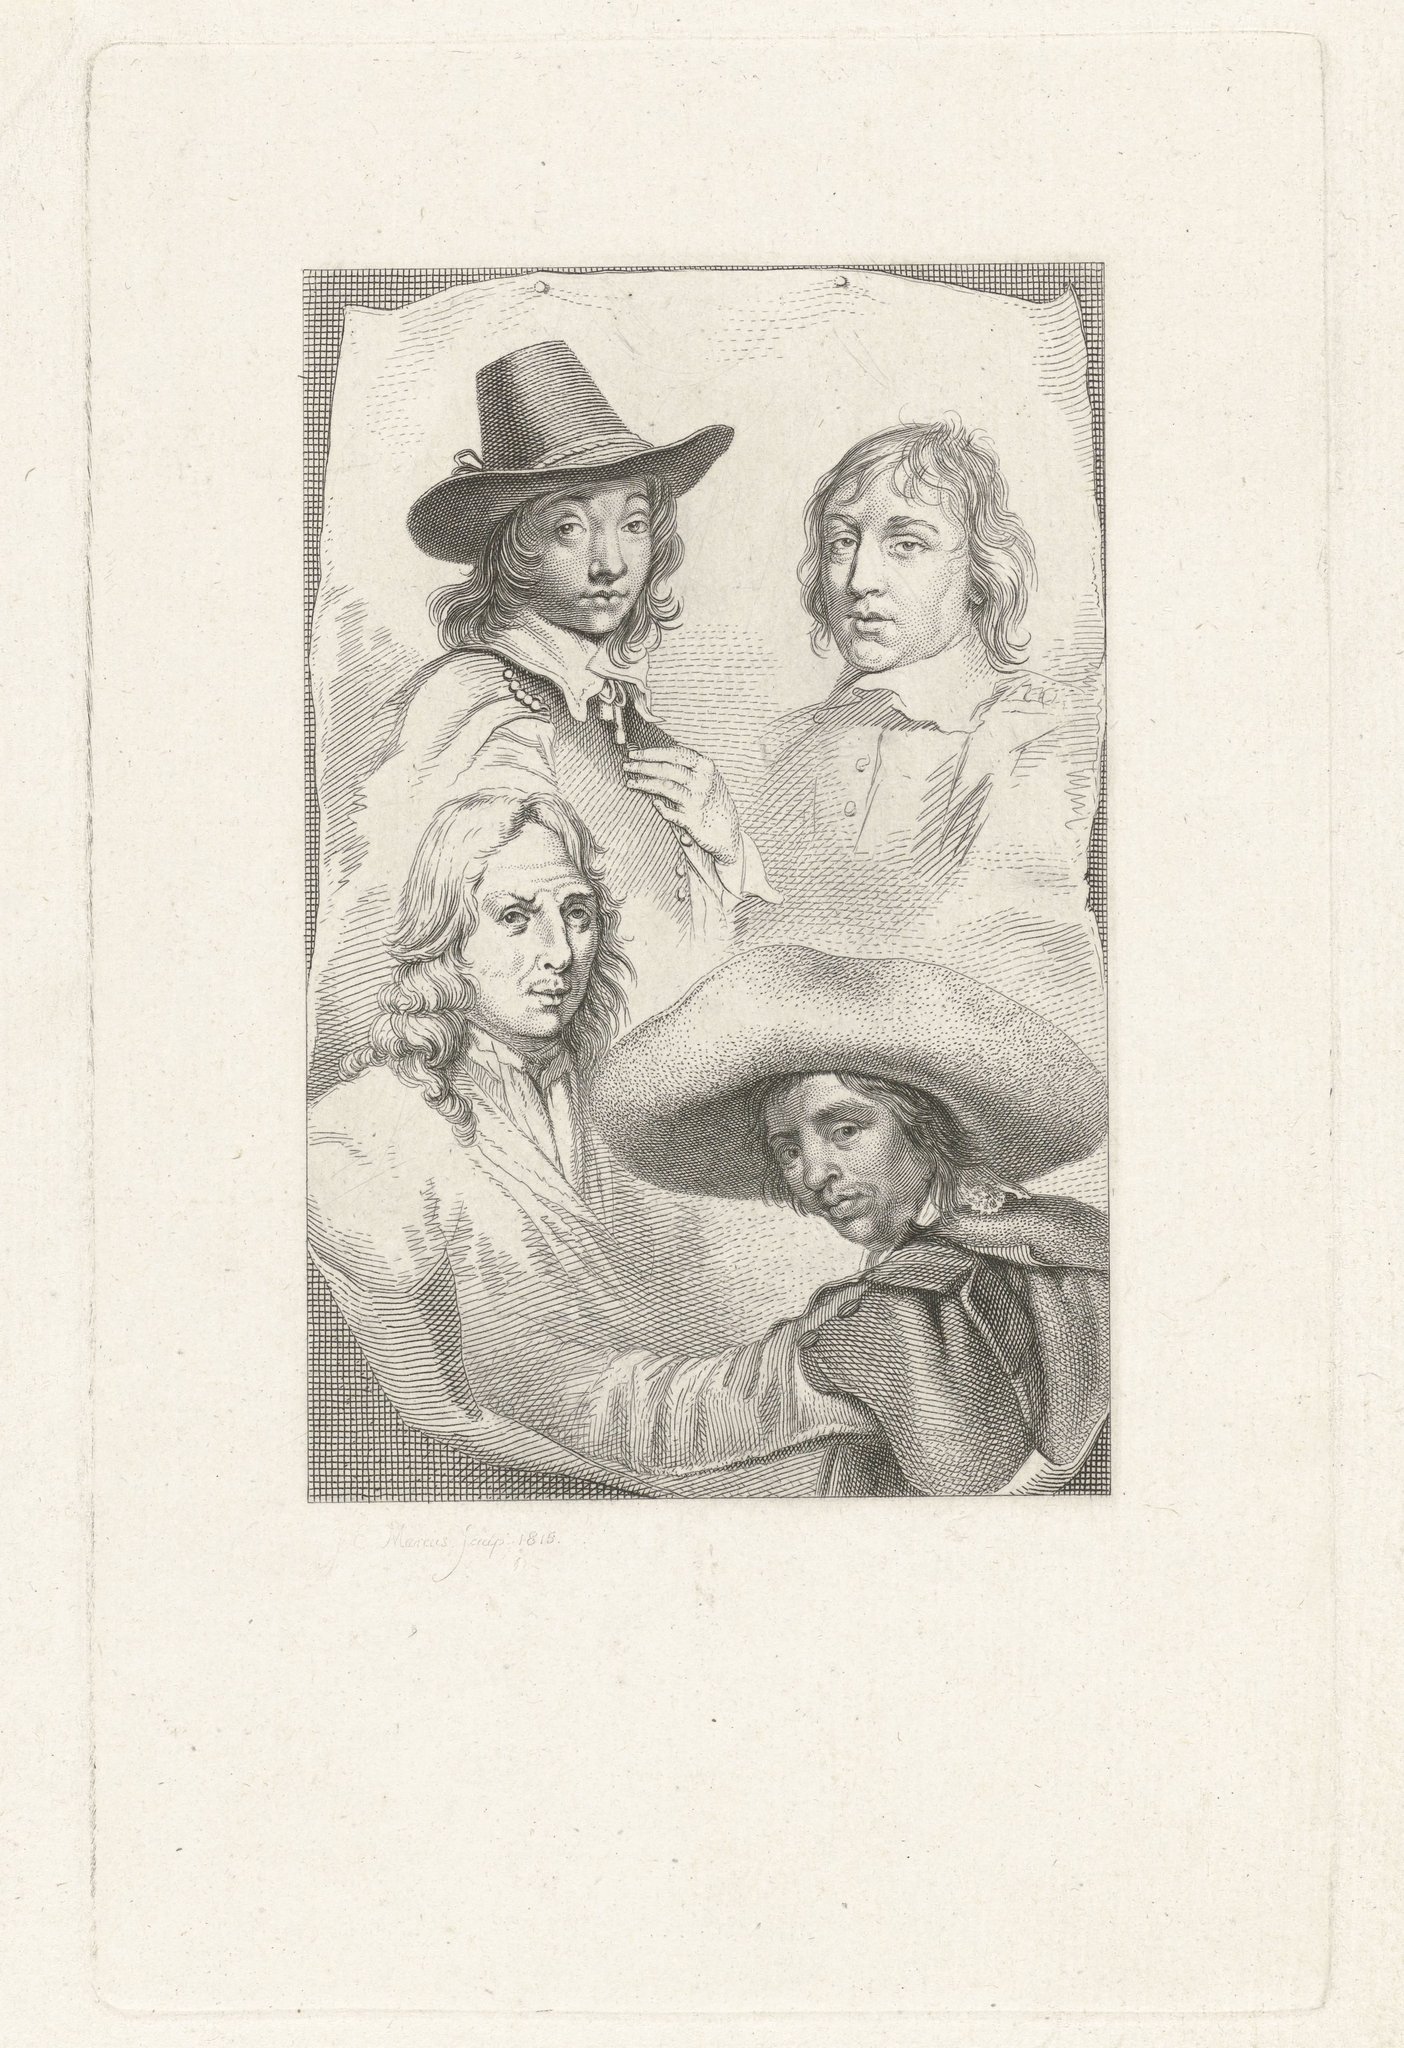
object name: print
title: Portretten van Cornelis Visscher, Jan de Visscher, Richard Brakenburg en Quiringh Gerritsz. van Brekelenkam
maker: jacob ernst marcus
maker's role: draughtsman, print maker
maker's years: 1774-1826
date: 1815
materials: paper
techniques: etching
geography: amsterdam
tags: richard brakenburg, haarlem, jan de visscher, leiden, draughtsman, quiringh gerritsz. van brekelenkam, painter, cornelis visscher (ii)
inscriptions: collector's mark: Lugt 2228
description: Latere staat van de prent ook gebruikt in: Roeland van Eynden, Adriaan van der Willigen, Geschiedenis der vaderlansche schilderkunst, sedert de helft der XVIII eeuw. Haarlem, A. Loosjes, Pz [vanaf dl 3: Wed. A. Loosjes], 4 dln., 1816-40.